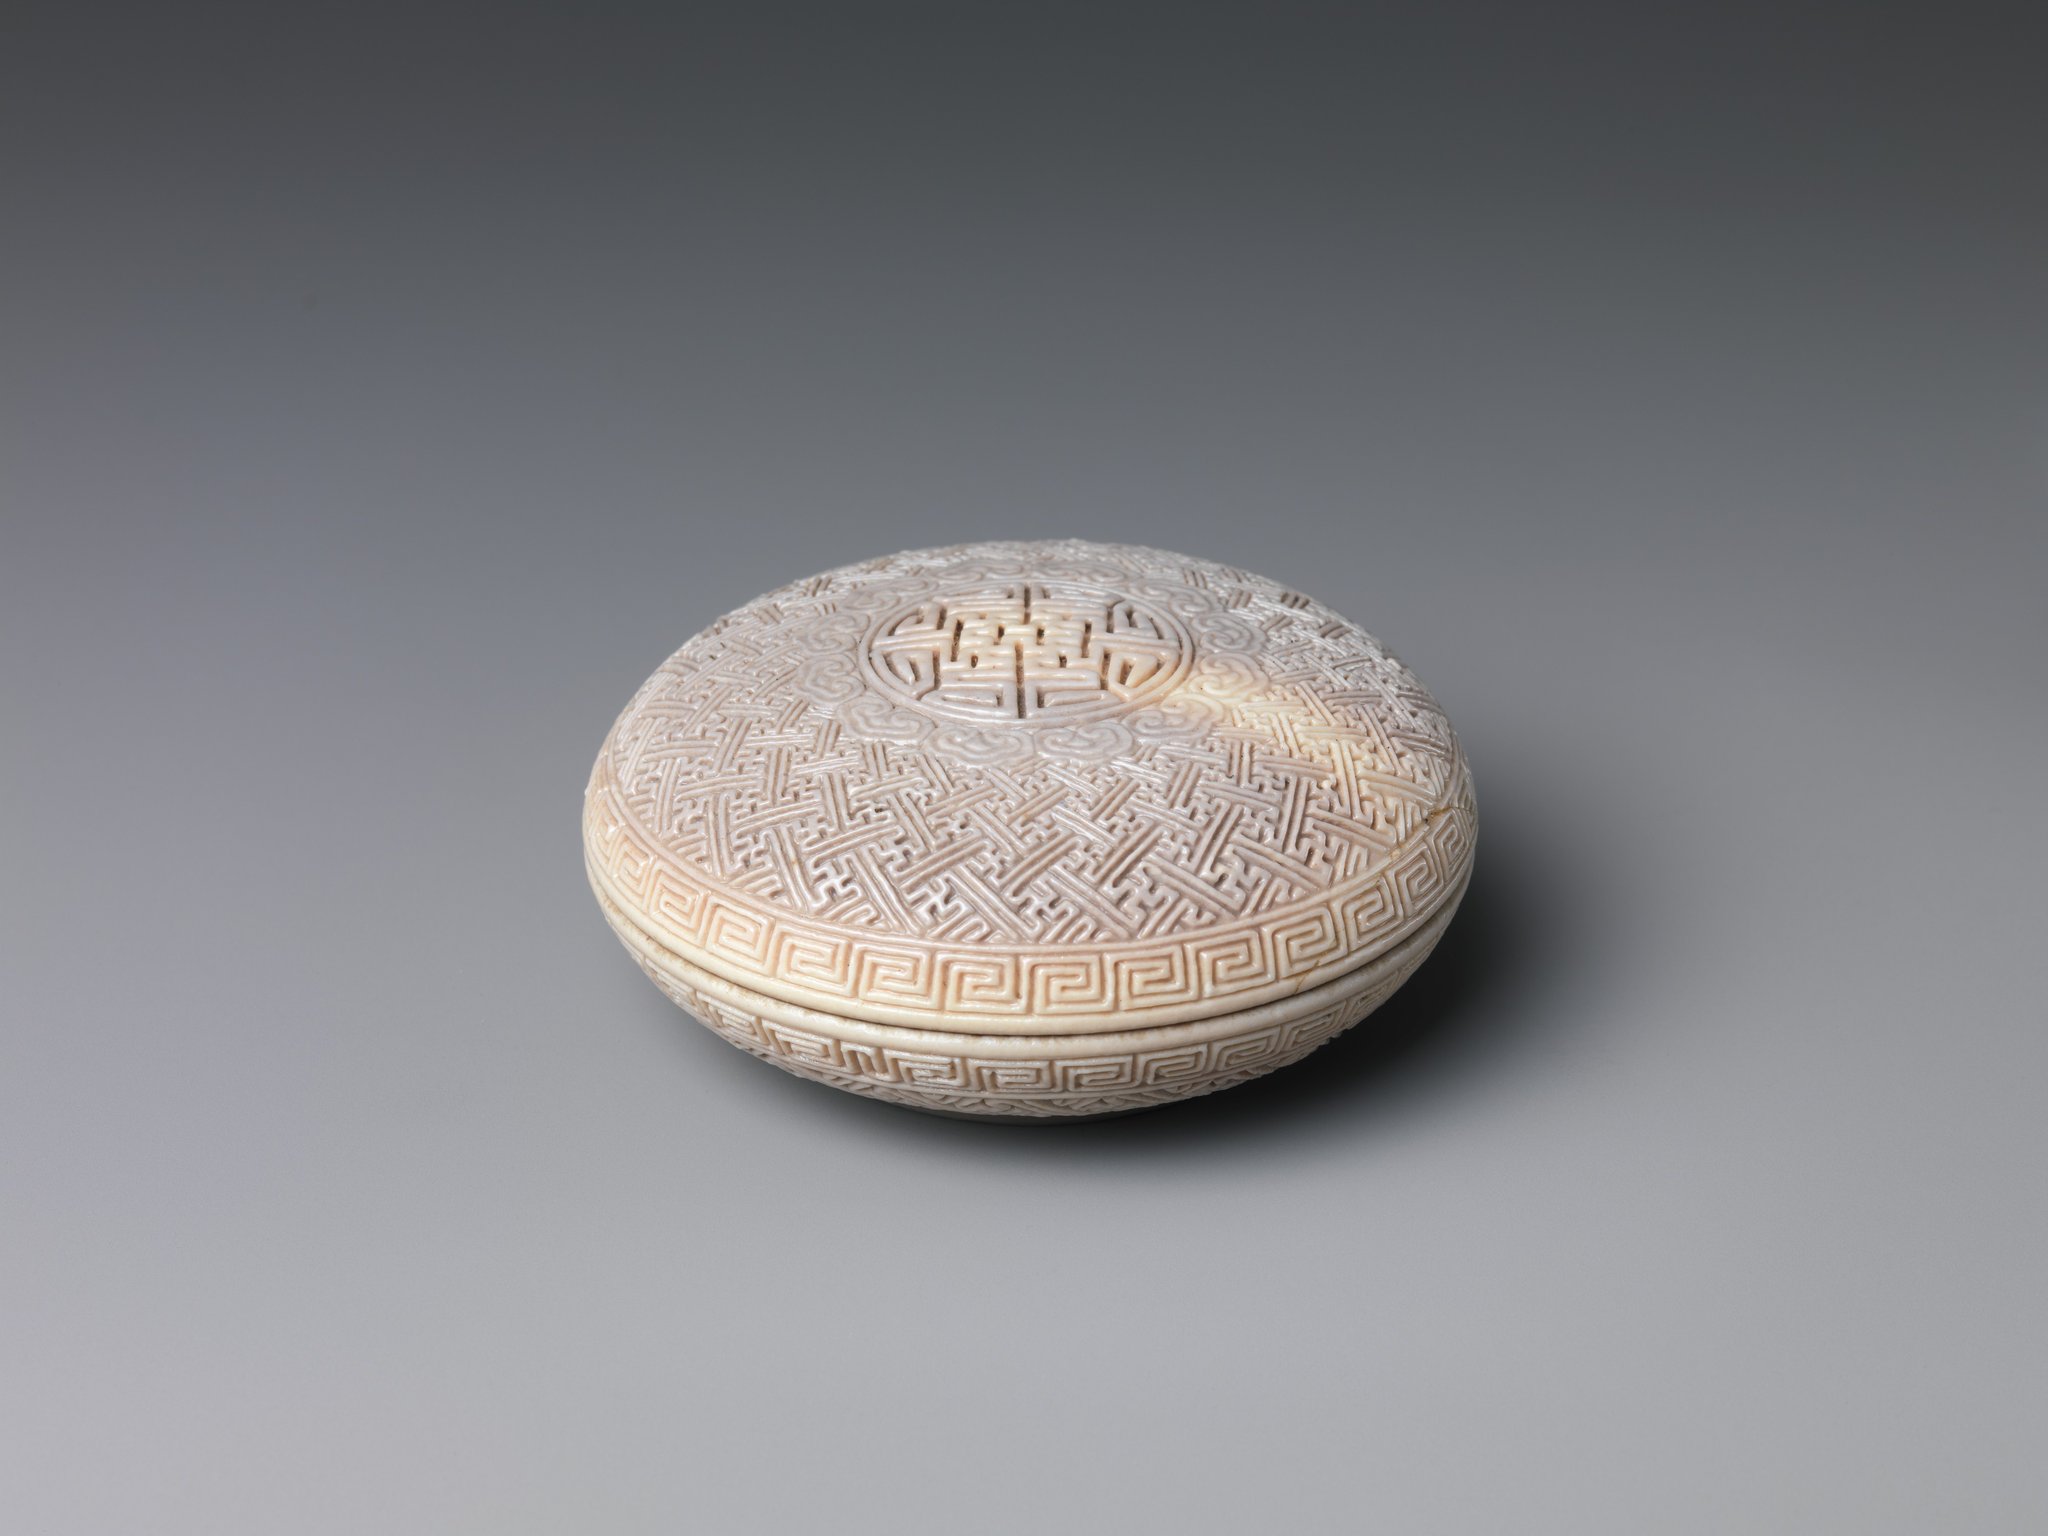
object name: box with cover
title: Box with Geometric Patterns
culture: chinese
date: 1701-1800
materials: porcelain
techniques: carving